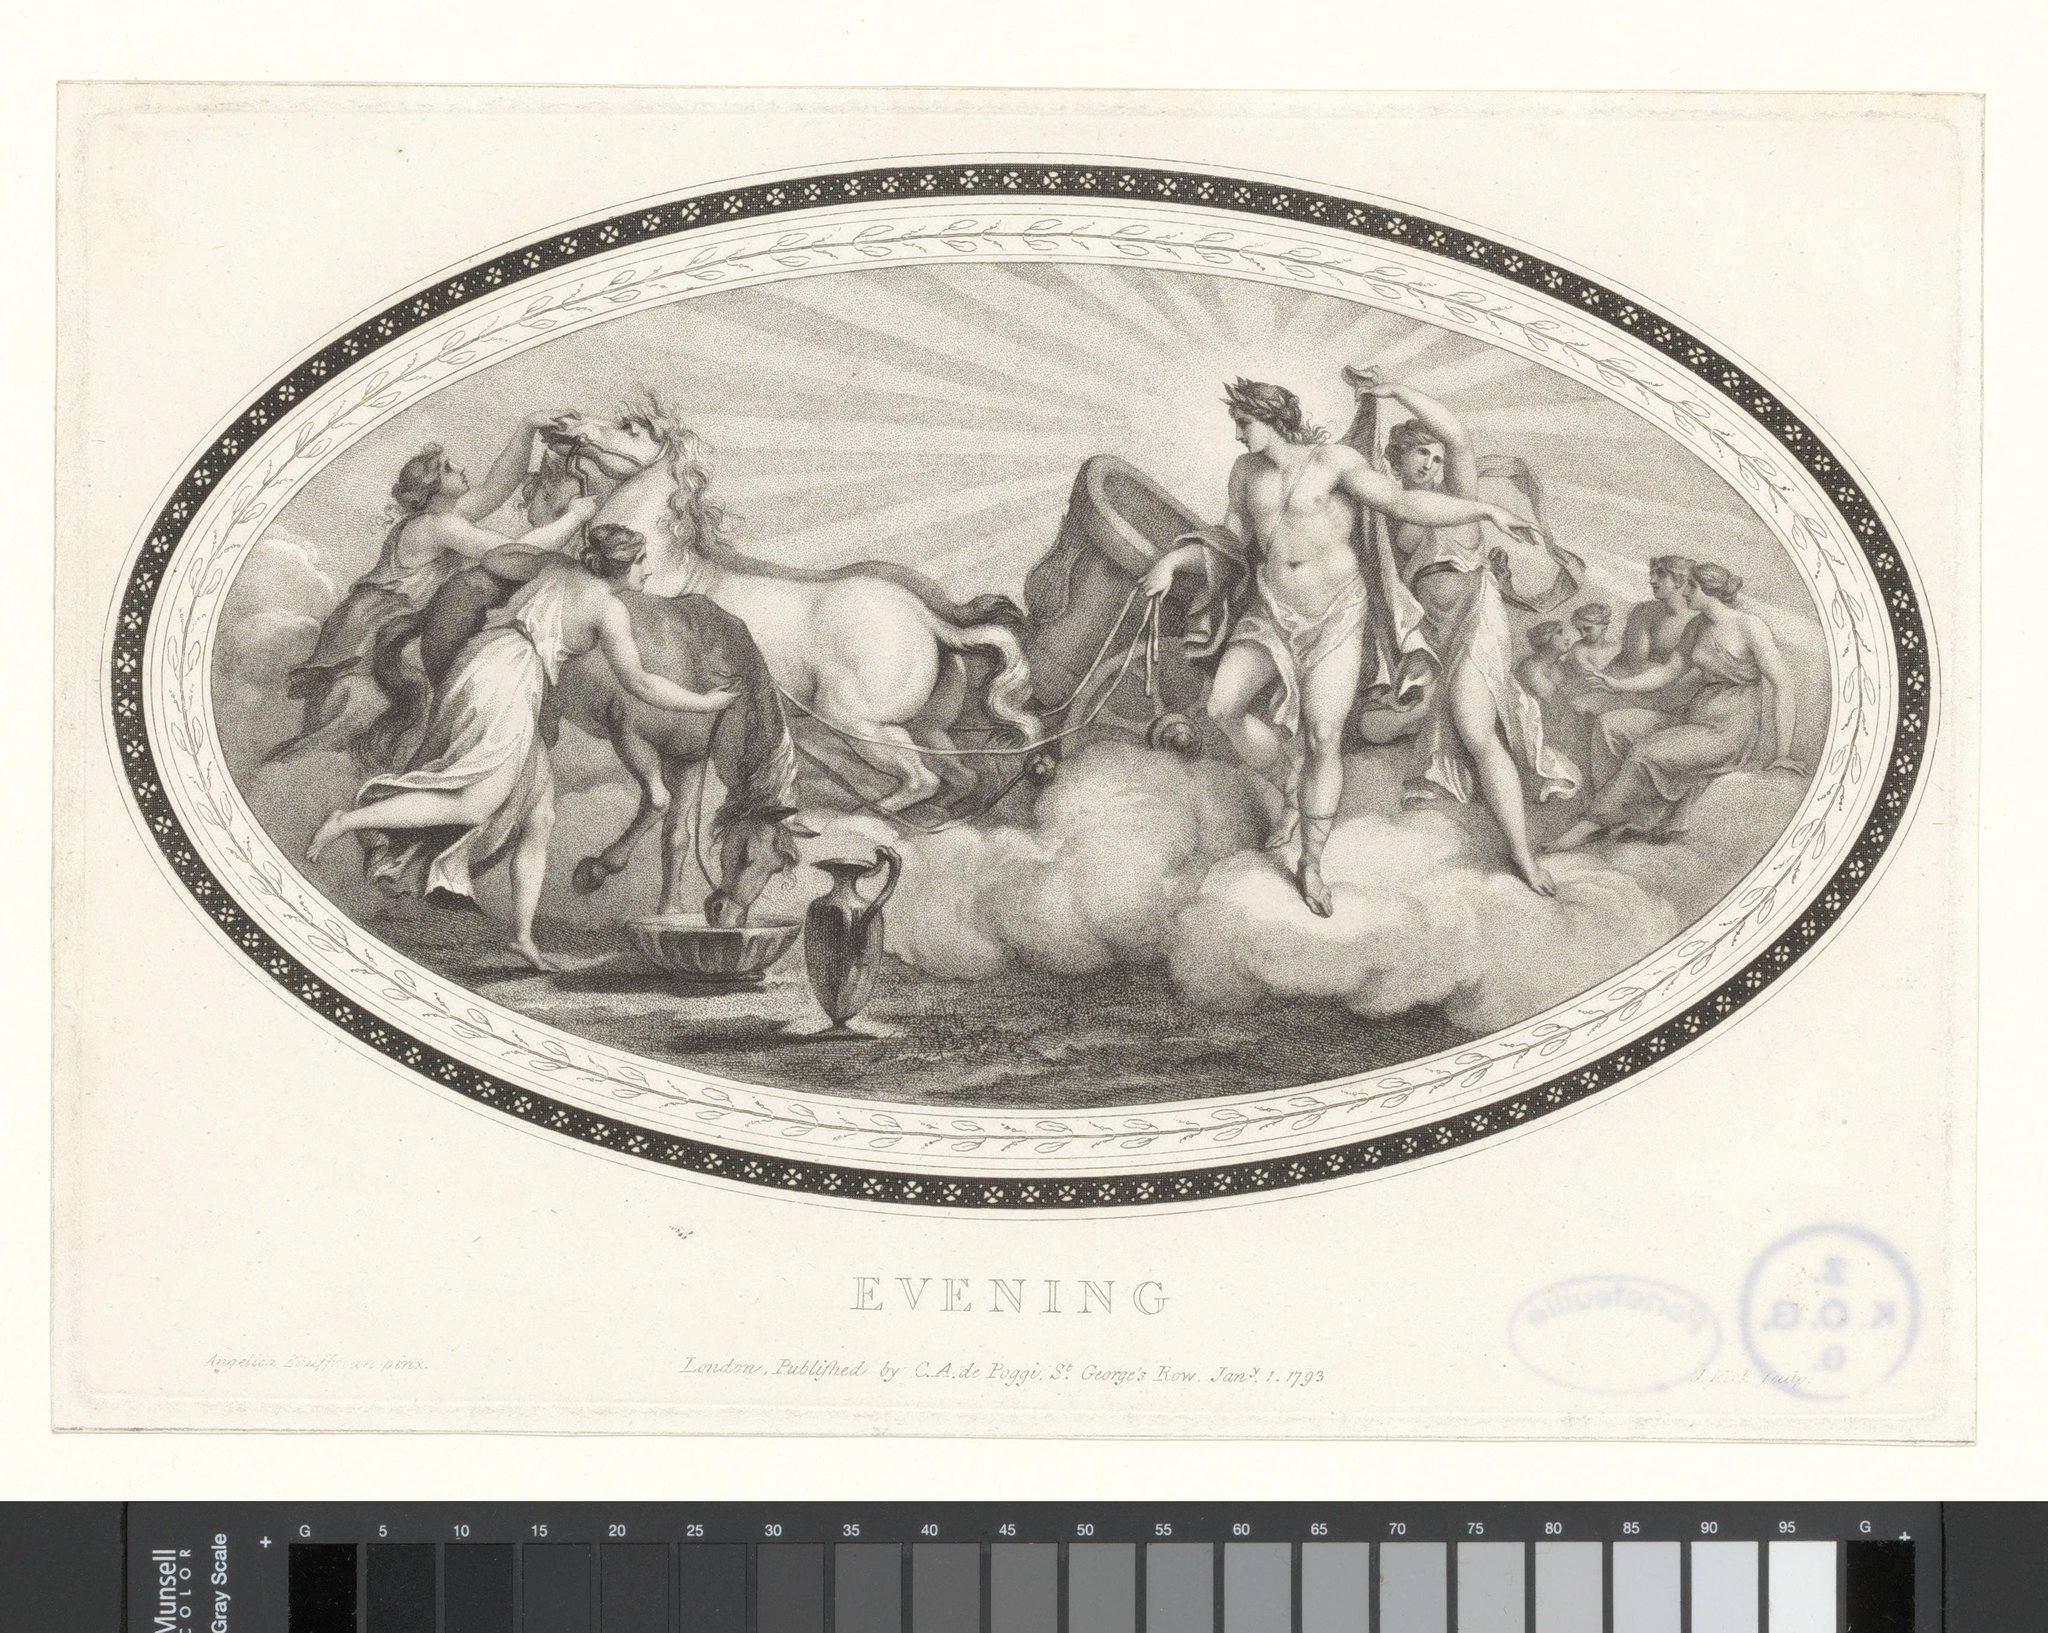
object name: print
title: Evening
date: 1793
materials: paper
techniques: etching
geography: london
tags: (story of) apollo (phoebus), morning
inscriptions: collector's mark: Lugt 1641, stamp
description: Apollo stapt uit zijn wagen aan het einde van de dag. Zijn paarden drinken uit een bekken. Onderwerpsrubrieken binnen de Atlas Zeden en Gewoonten: Zeden en Gewoonten in engeren zin. Volksleven. Zinnebeeldige voorstellingen uit het volkleven op serieprenten. Maanden en diversen (allegorieën).